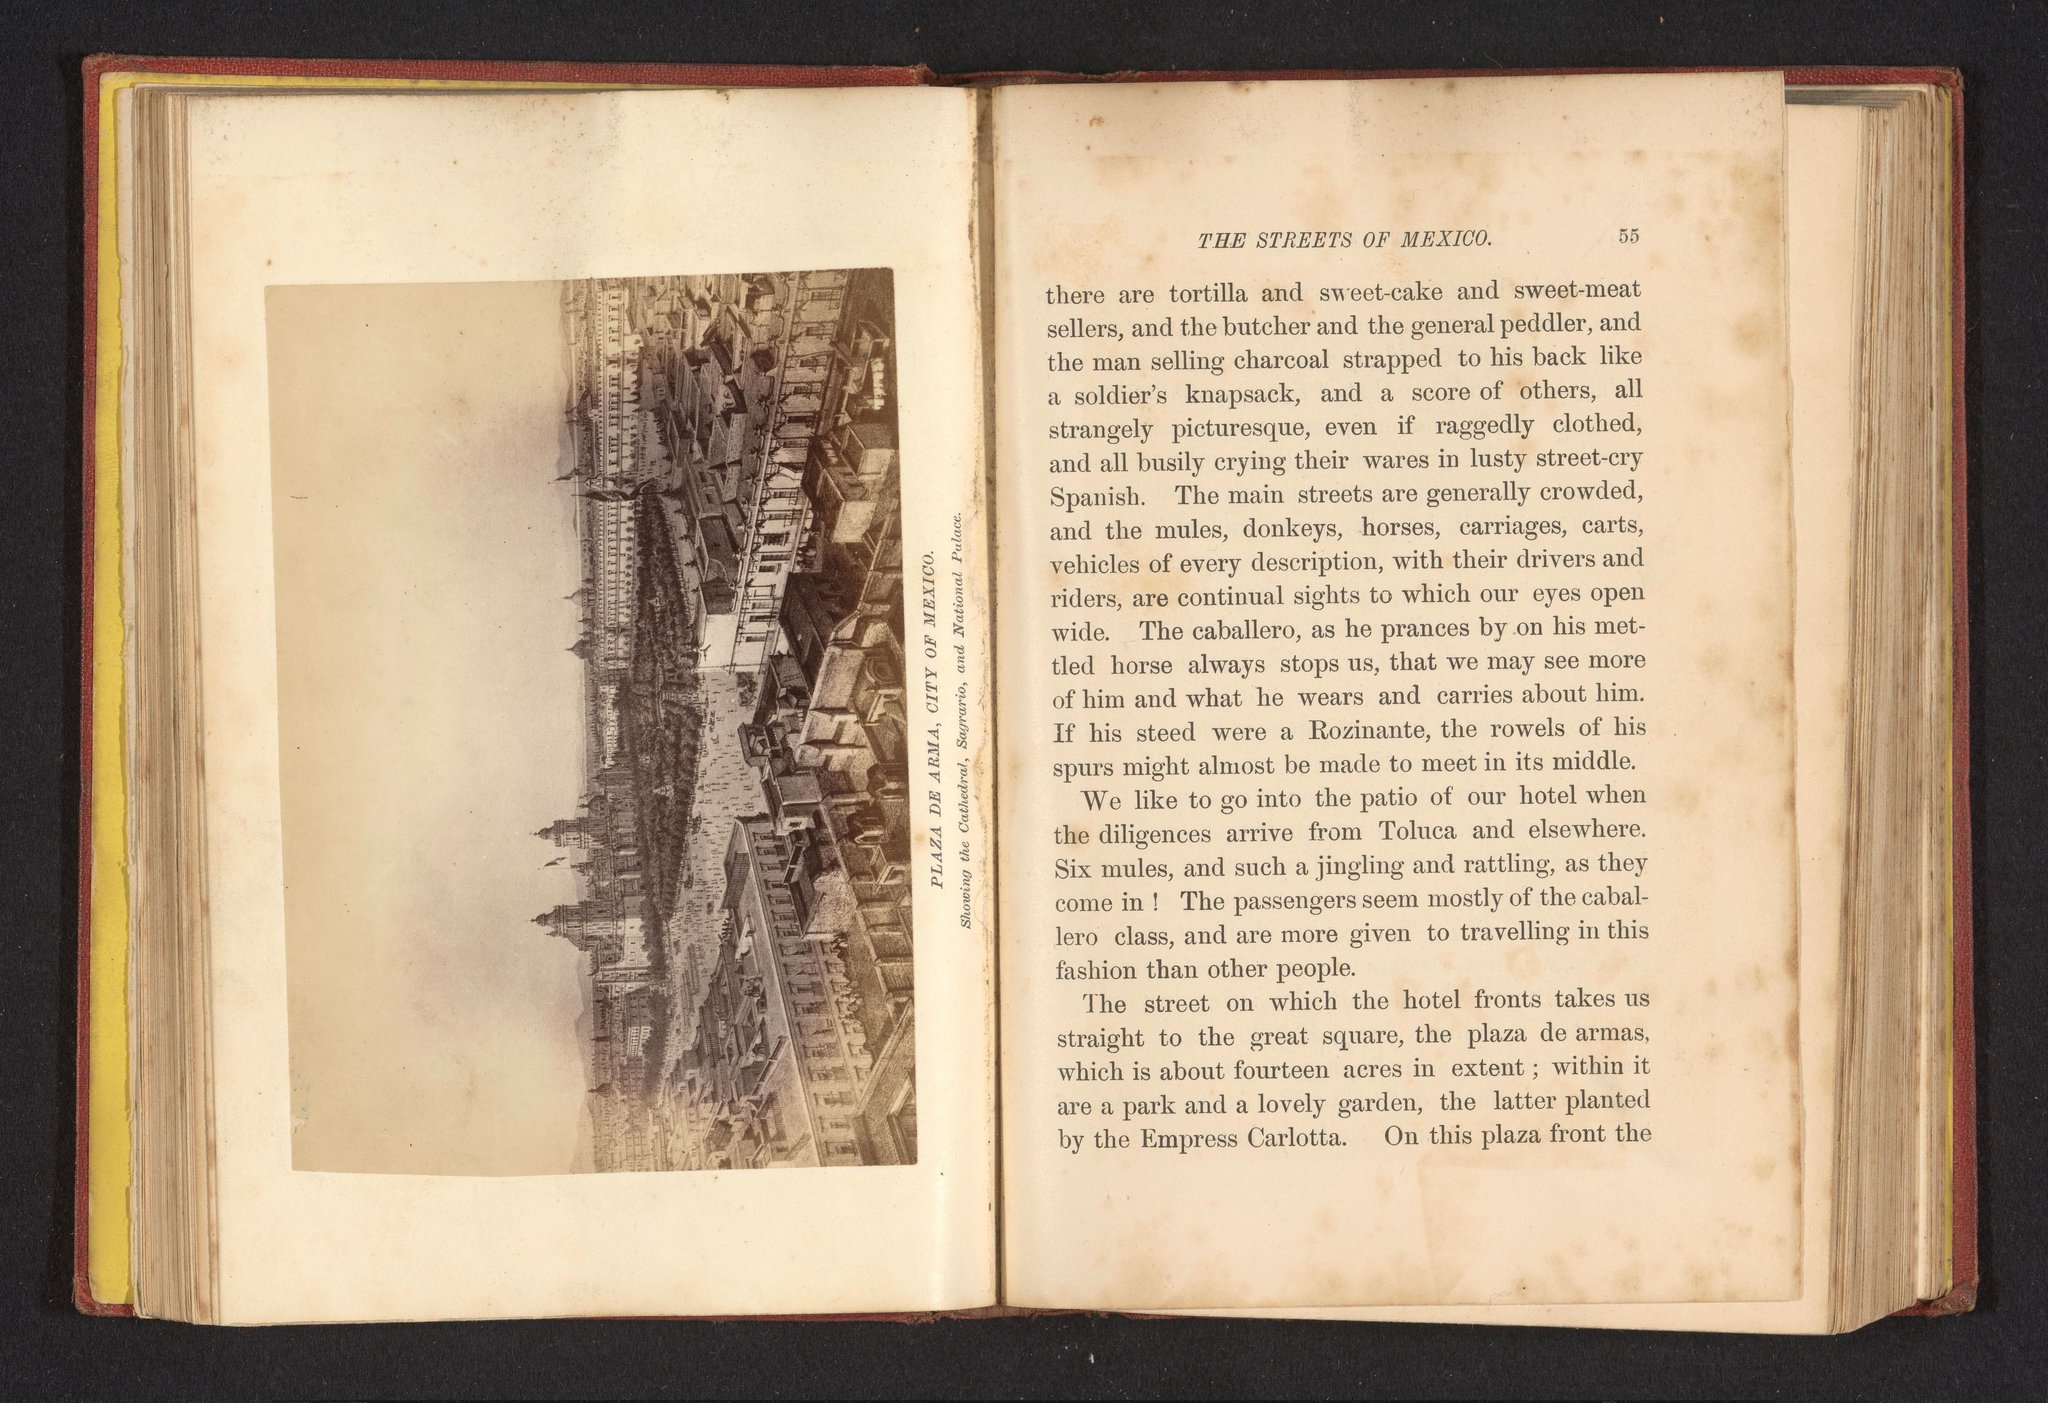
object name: photograph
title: Plaza de Arma, City of Mexico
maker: Anonymous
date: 1870-1880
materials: photographic support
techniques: albumen print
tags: city-view in general; 'veduta'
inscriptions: inscription: ‘Showing the Cathedral, Sagrario, and National Palace.’